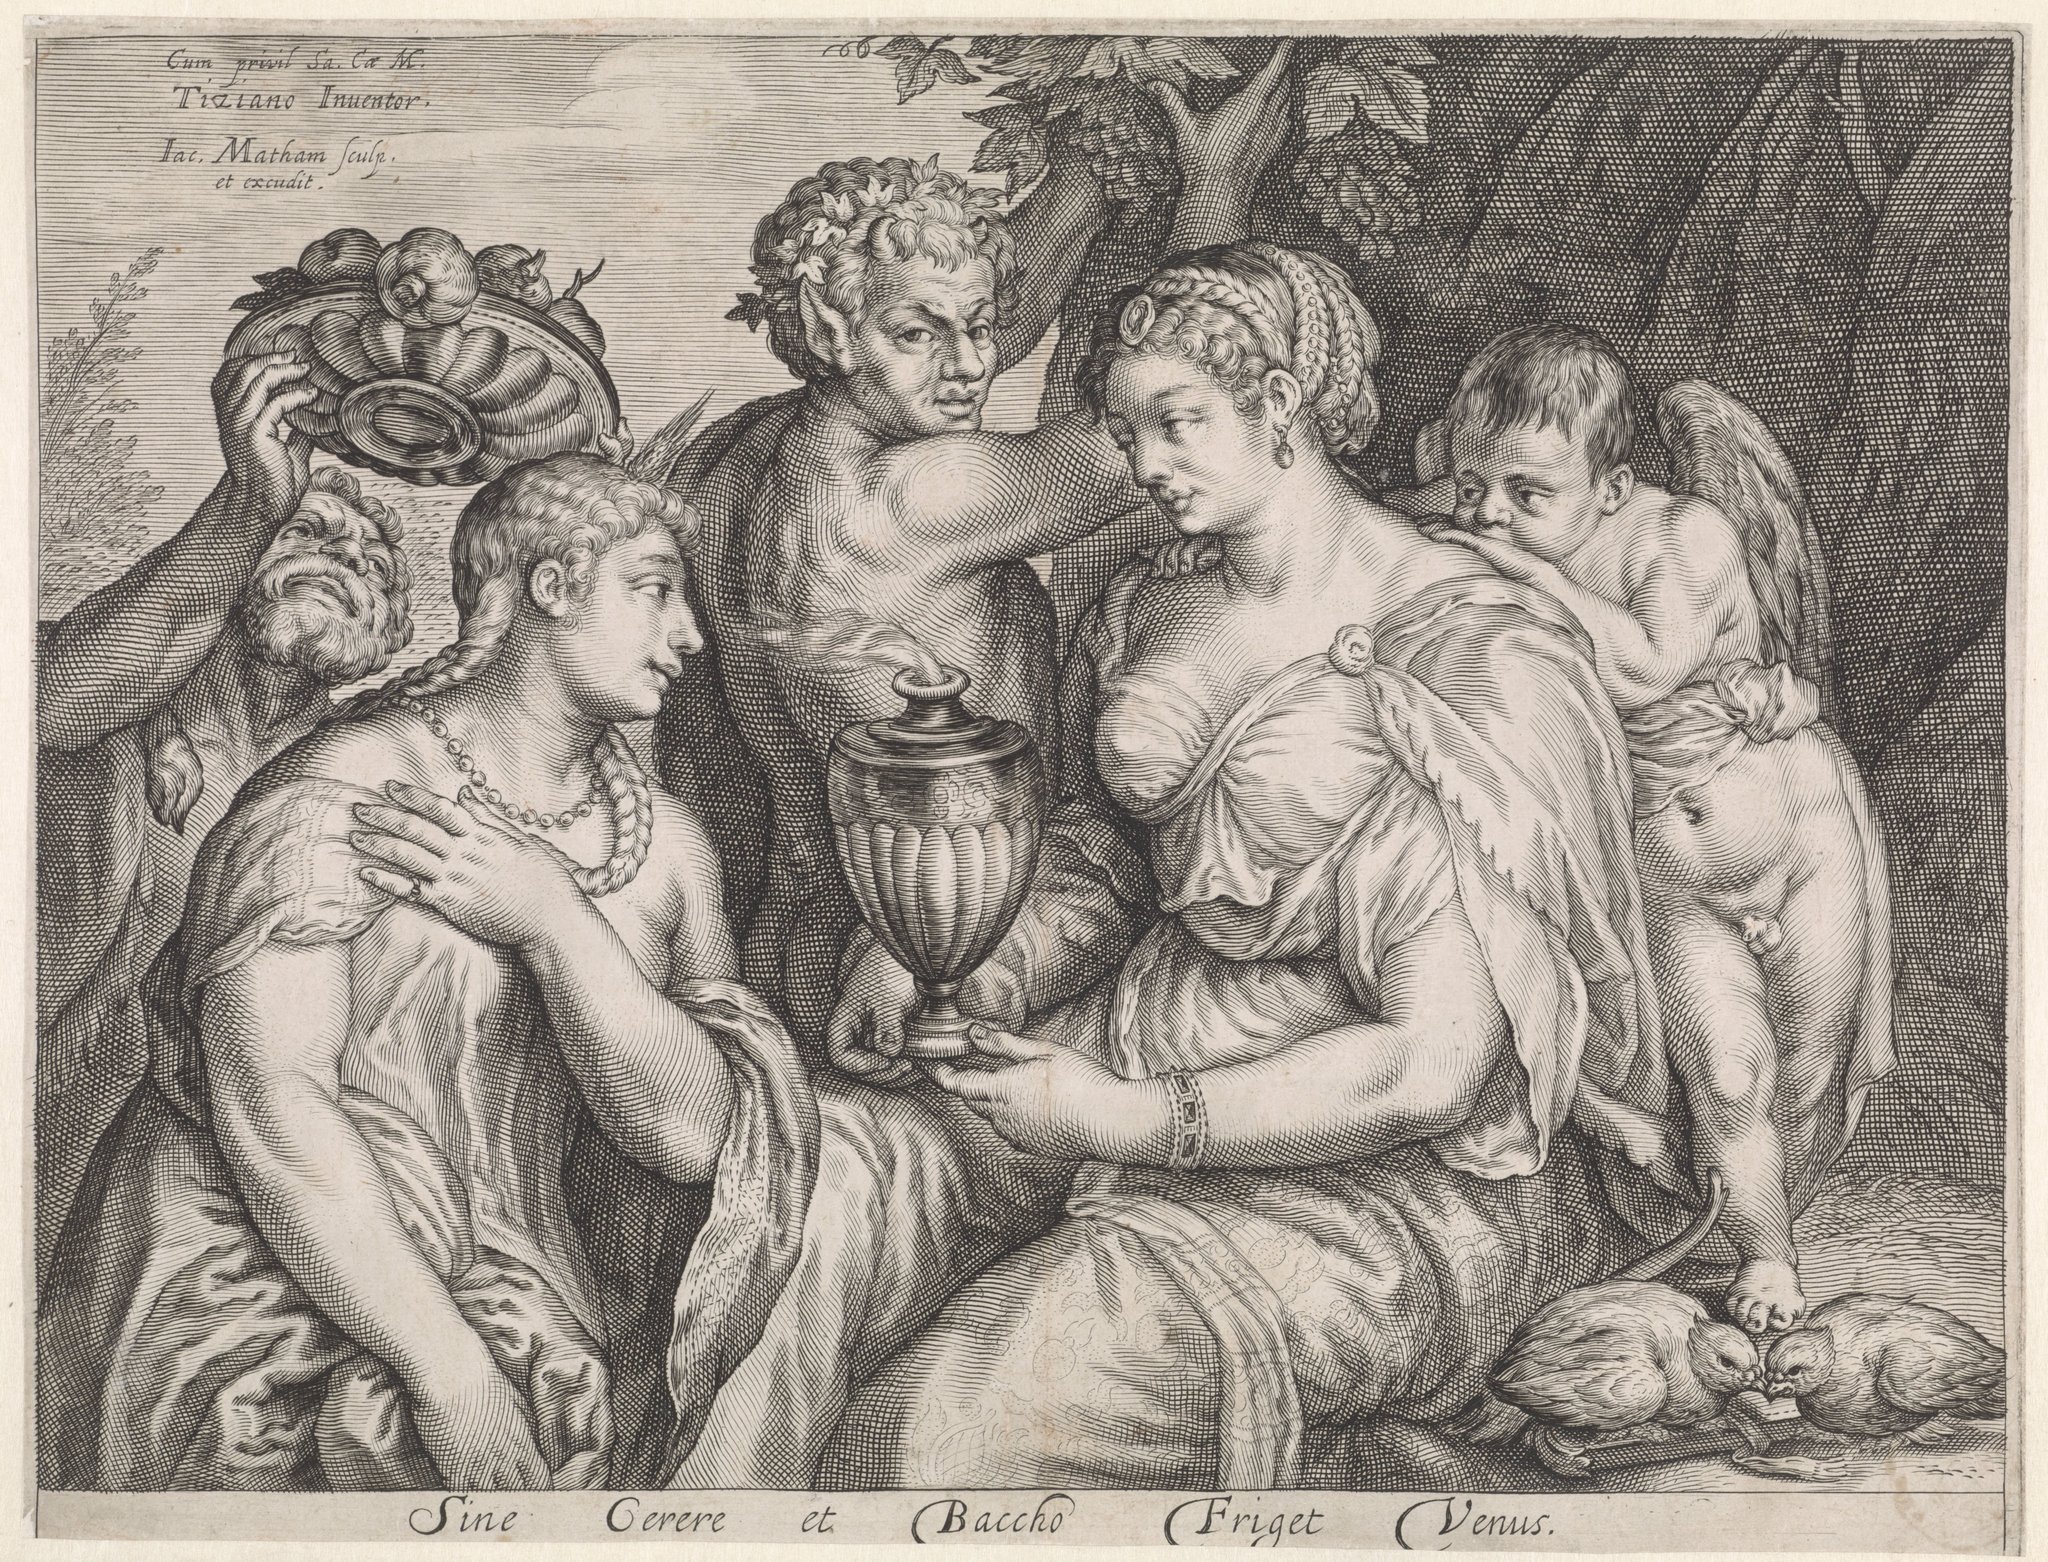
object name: print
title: Sine Cerere et Baccho friget Venus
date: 1599-1603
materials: paper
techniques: engraving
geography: haarlem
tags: 'sine cerere et baccho friget venus'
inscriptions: collector's mark: Lugt 240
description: Venus en Amor vergezeld door Ceres en Bacchus. Bacchus plukt druiven en Ceres' dienaar heeft een schaal met granaatappels bij zich. Venus heeft een rokende pot vast.